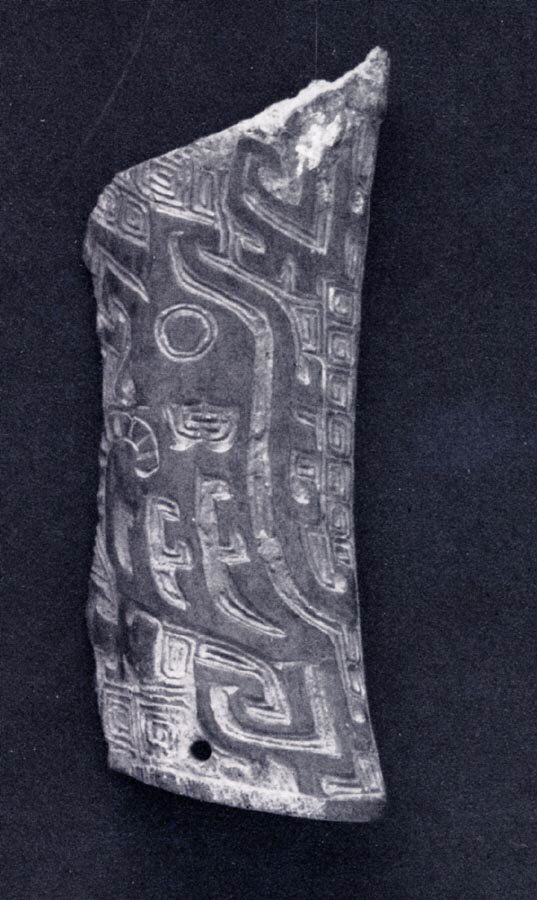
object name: spatula fragment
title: Fragment of a Spatula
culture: chinese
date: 1300-1001 BCE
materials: bone